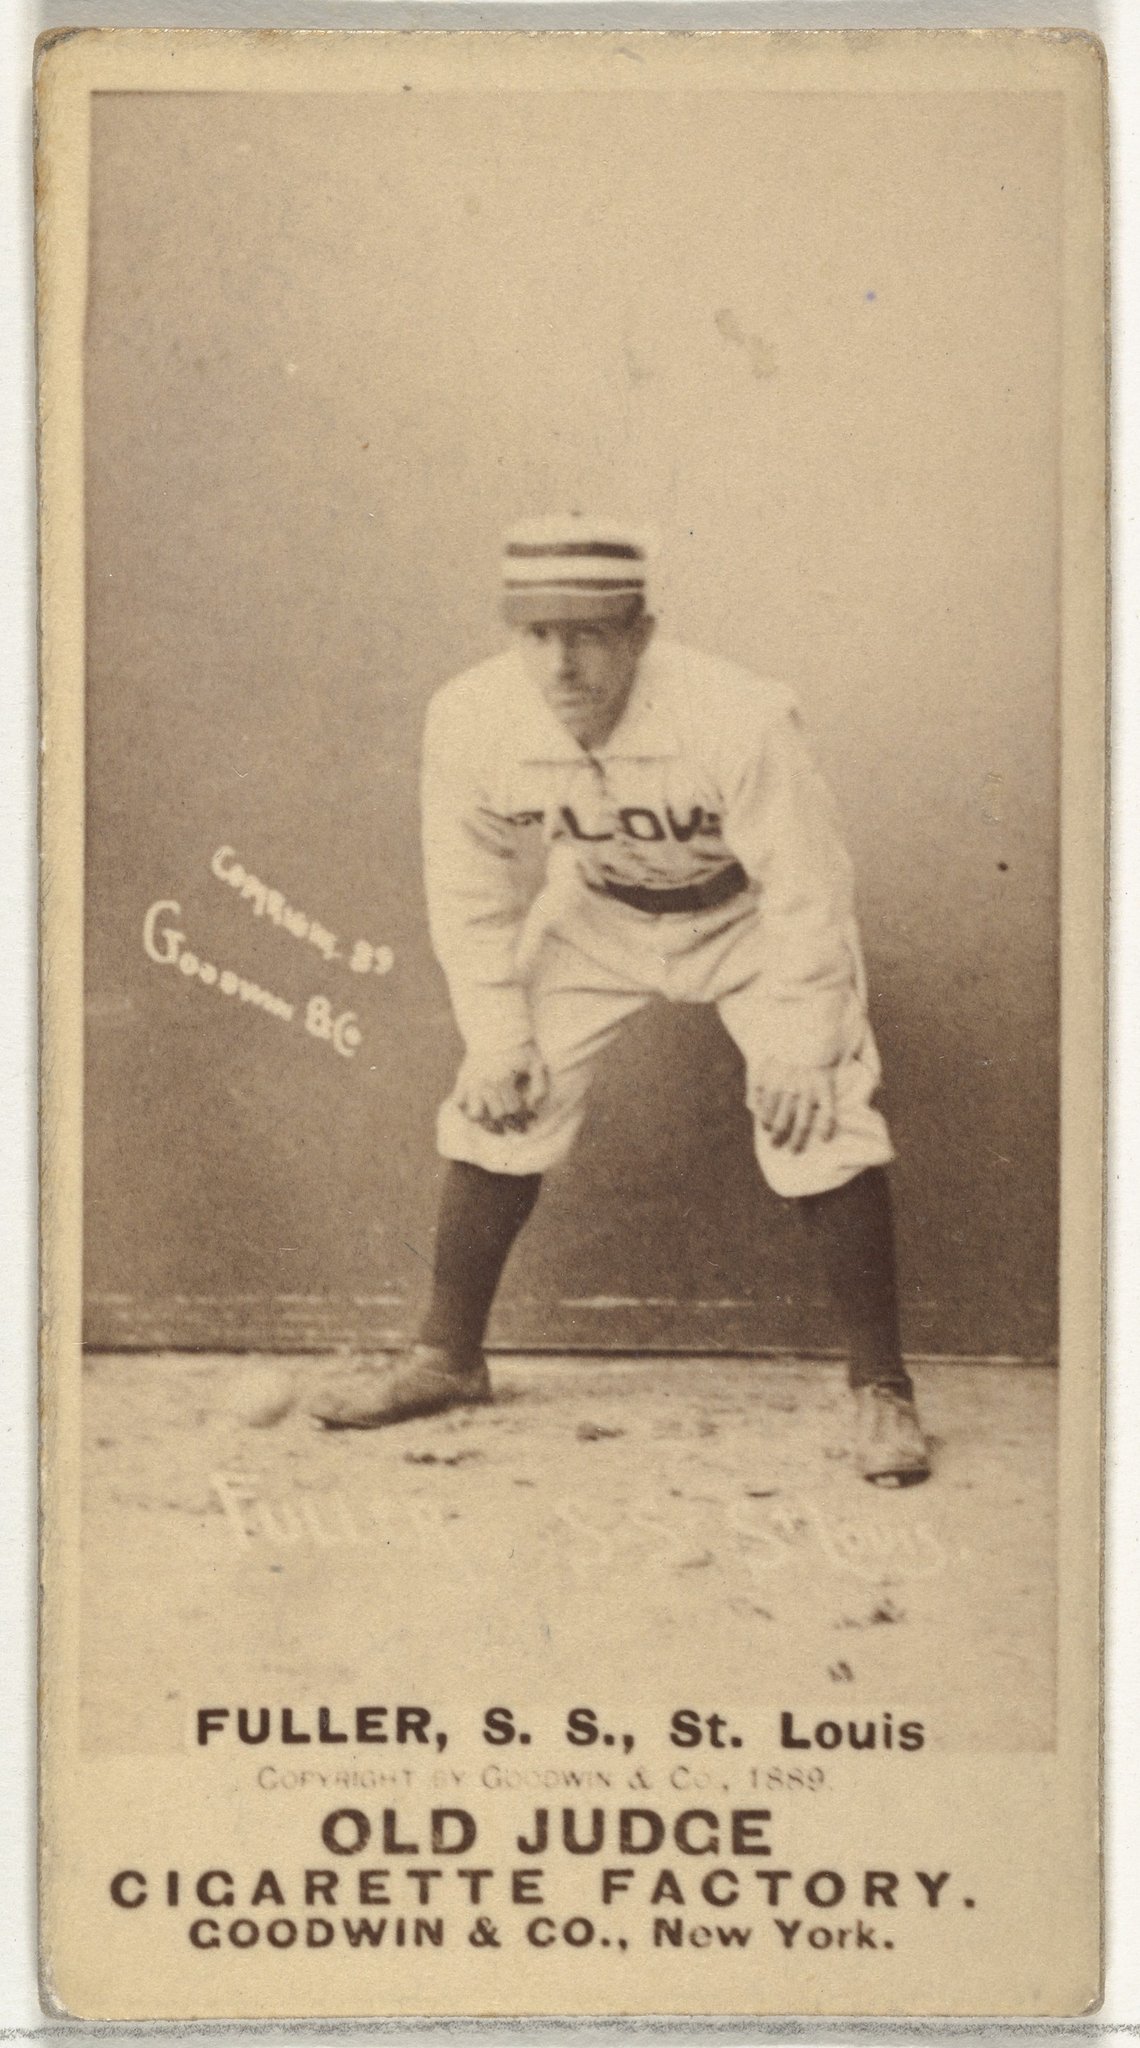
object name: baseball card, photograph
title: William Benjamin "Shorty" Fuller, Shortstop, St. Louis Browns, from the Old Judge series (N172) for Old Judge Cigarettes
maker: goodwin & company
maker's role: publisher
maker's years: 1850-1950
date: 1889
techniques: albumen silver print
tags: men,portraits,baseball,athletes